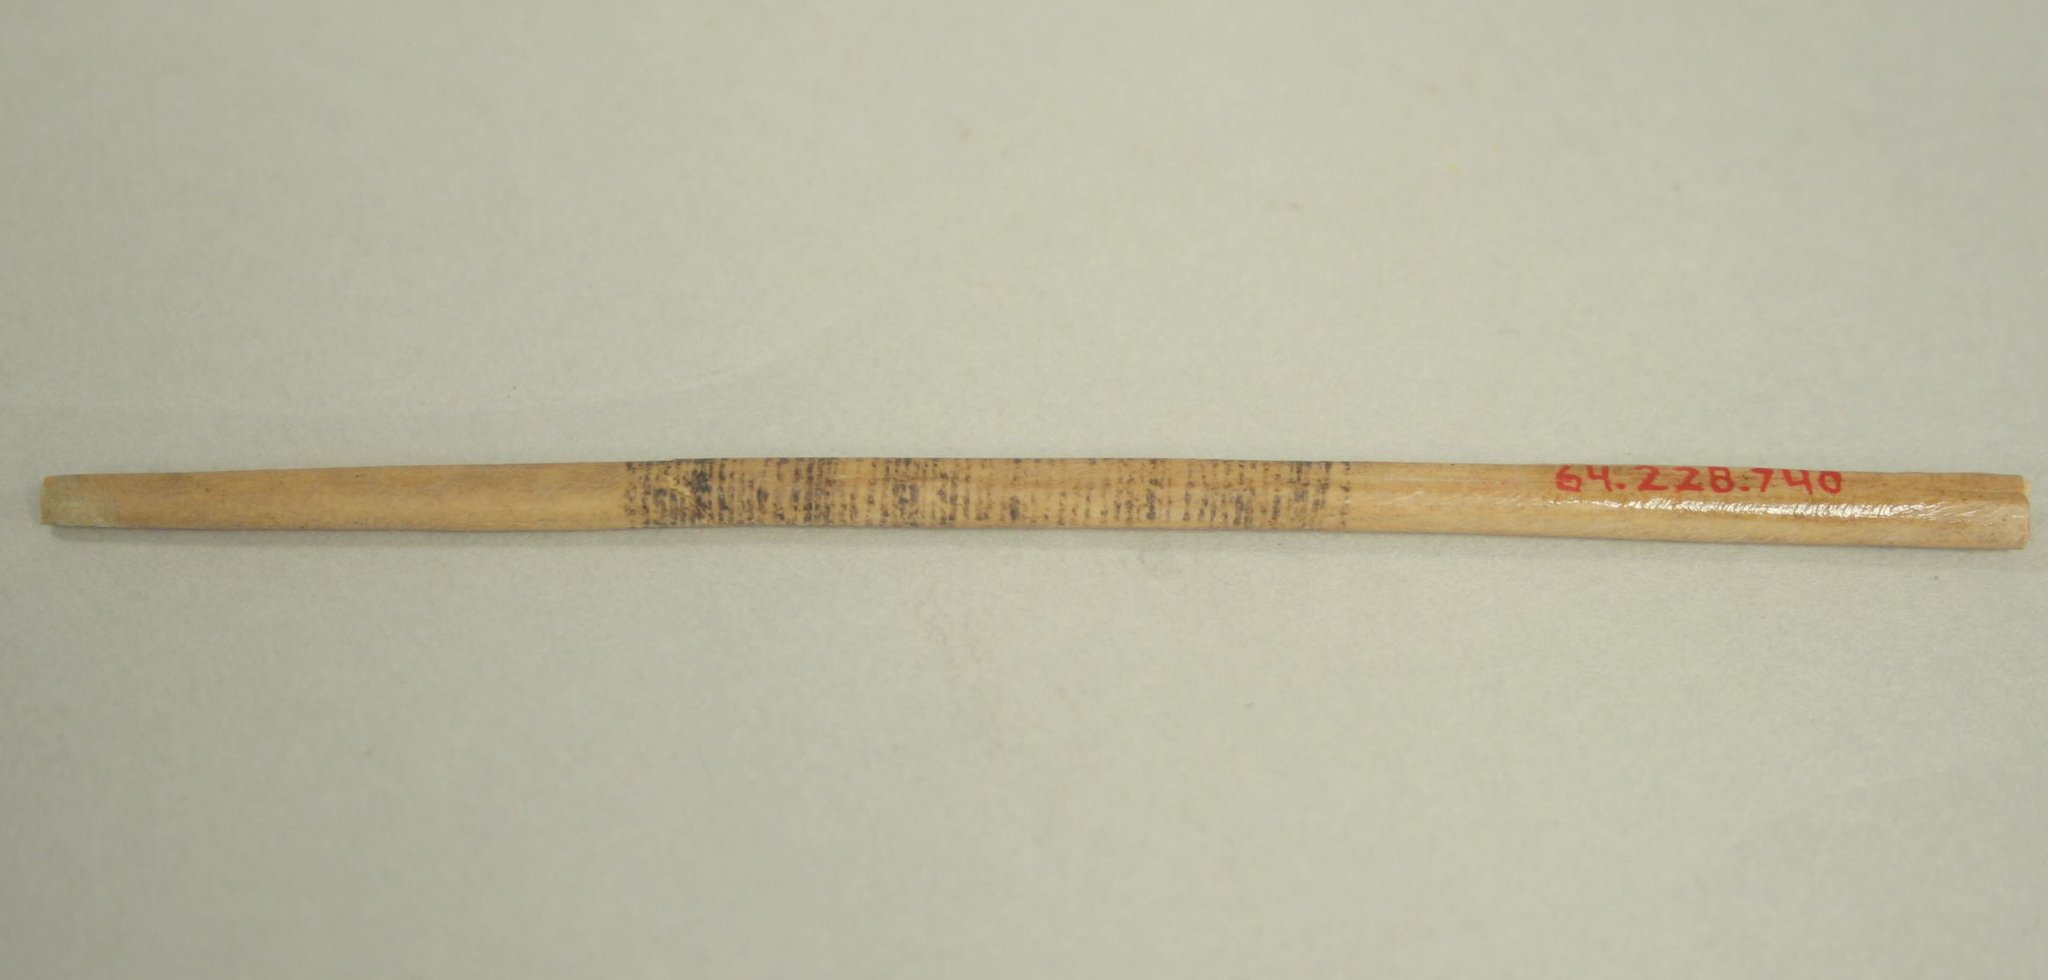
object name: bobbin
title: Bone Weaving Bobbin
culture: peruvian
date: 701-1566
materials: bone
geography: peru